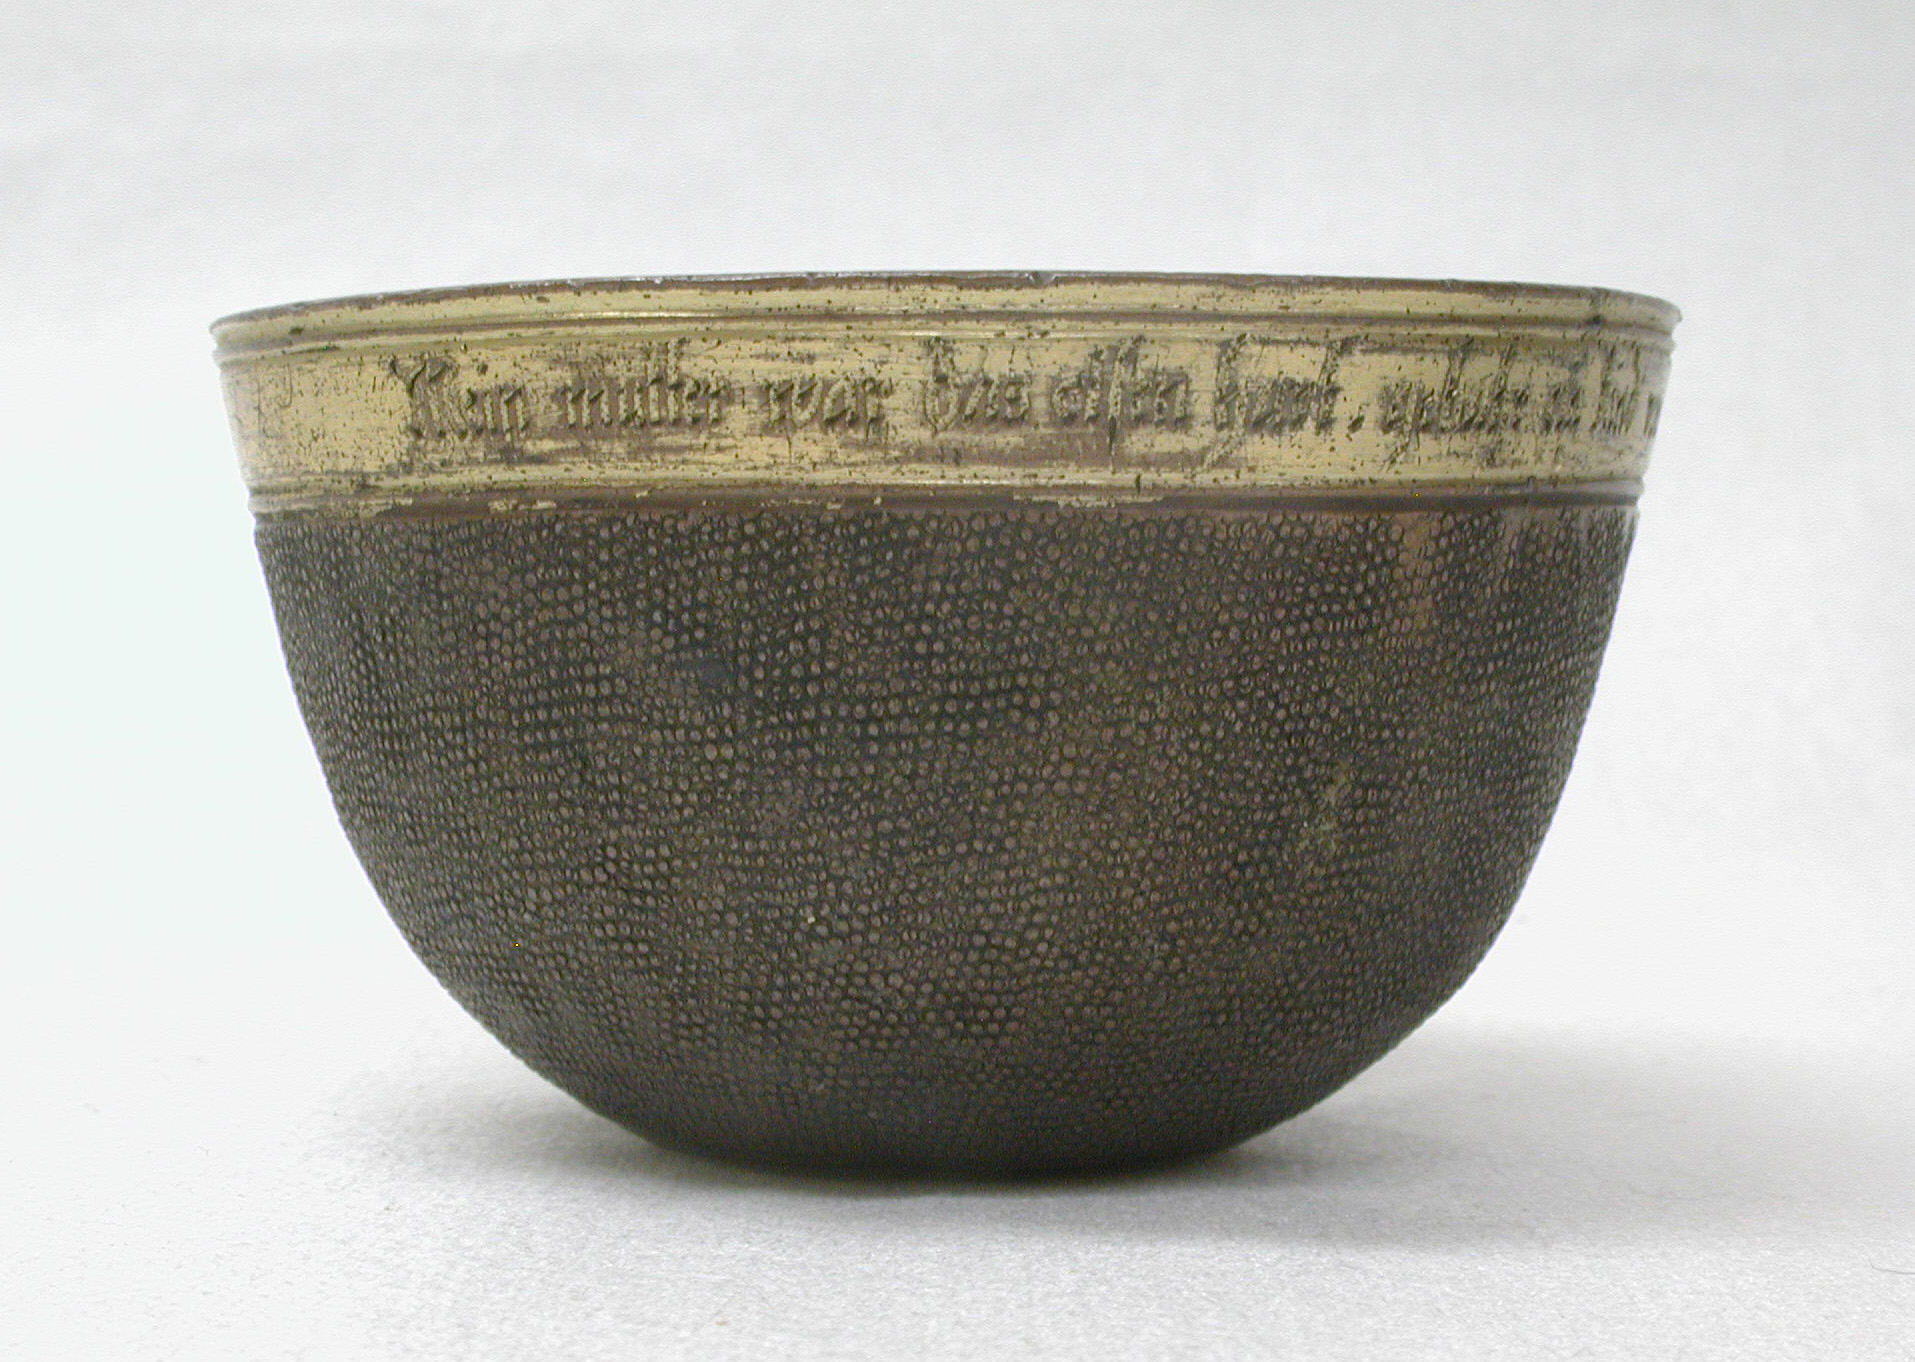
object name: cup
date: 1667-1733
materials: copper gilt